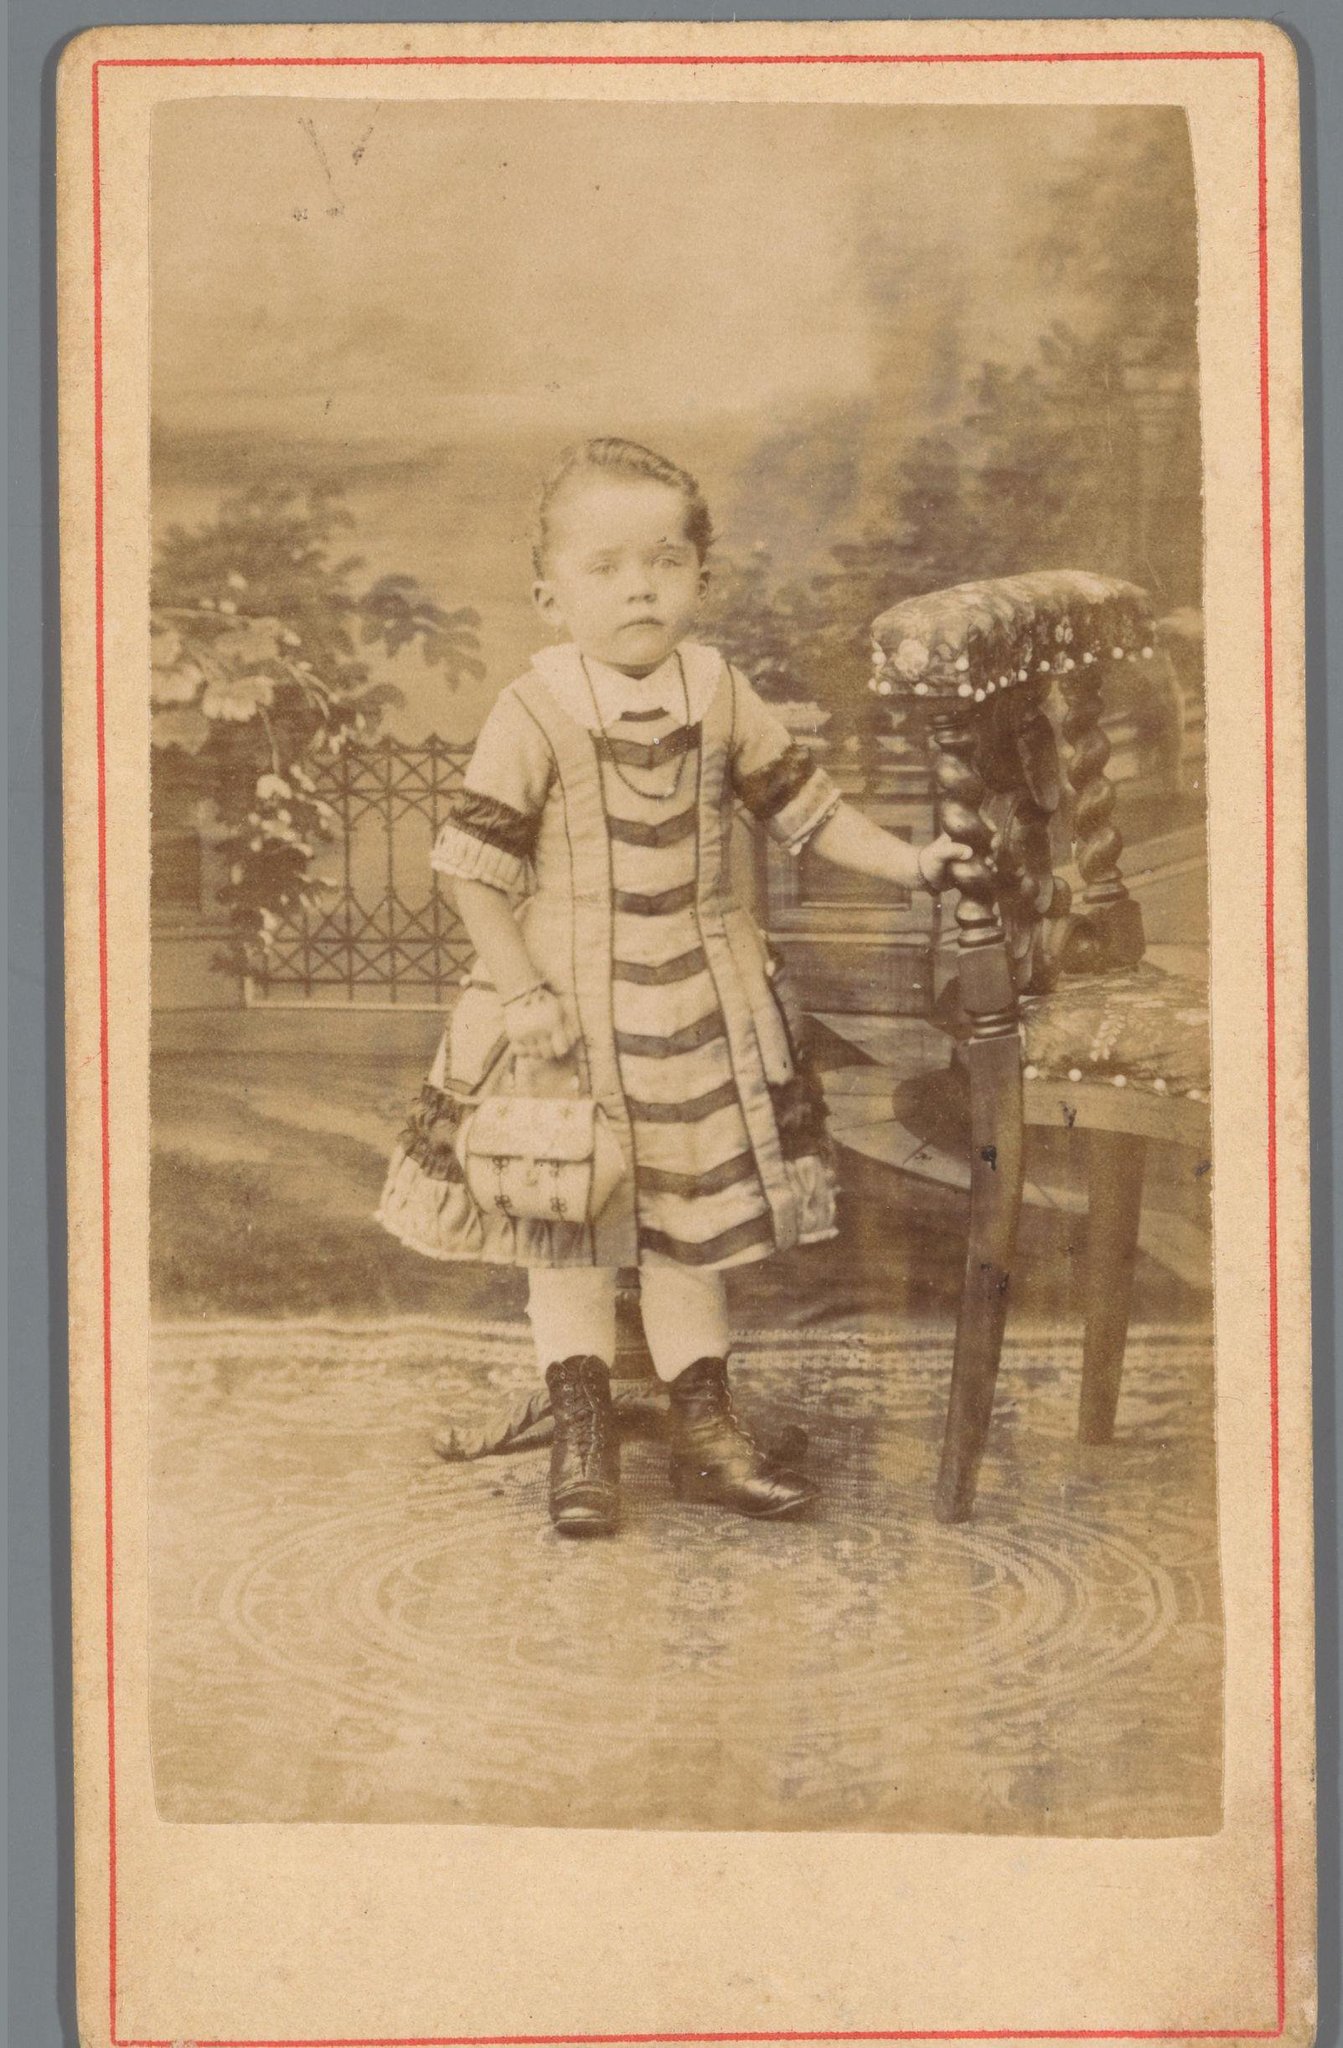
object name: photograph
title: Portret van een onbekend meisje naast een stoel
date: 1857-1885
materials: cardboard, paper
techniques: albumen print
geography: edam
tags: toddler, anonymous historical person portrayed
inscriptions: address: ‘EDAM-Voorhaven/ HILVERSUM/ ZONDAG EN MAANDAG/ HILVERSUM-Torenlaan’